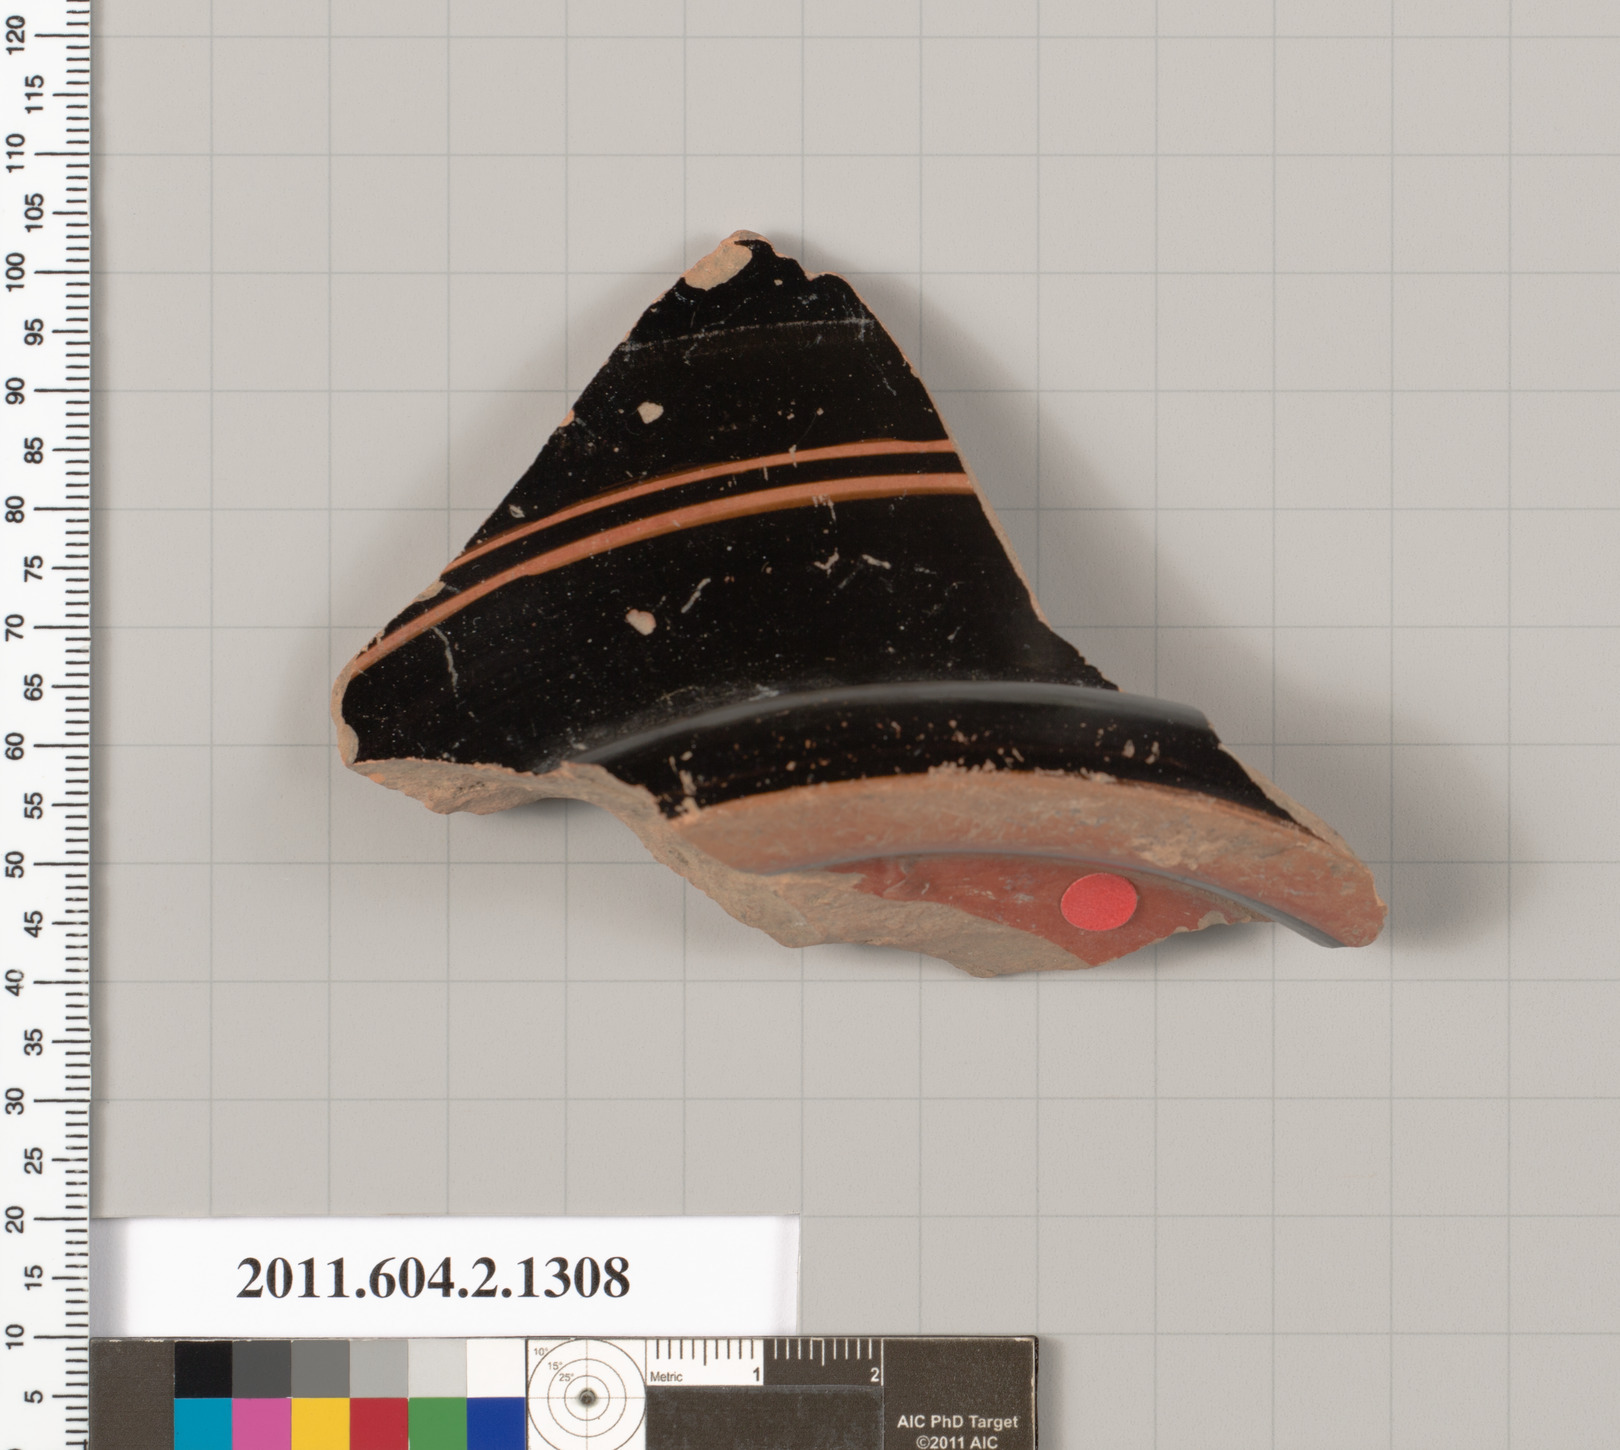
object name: skyphos fragment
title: Terracotta fragment of a skyphos (deep drinking cup)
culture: greek, attic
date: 500-451 BCE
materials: terracotta